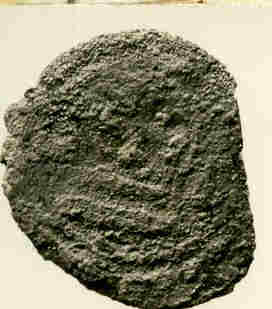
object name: coin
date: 701-900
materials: copper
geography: iran